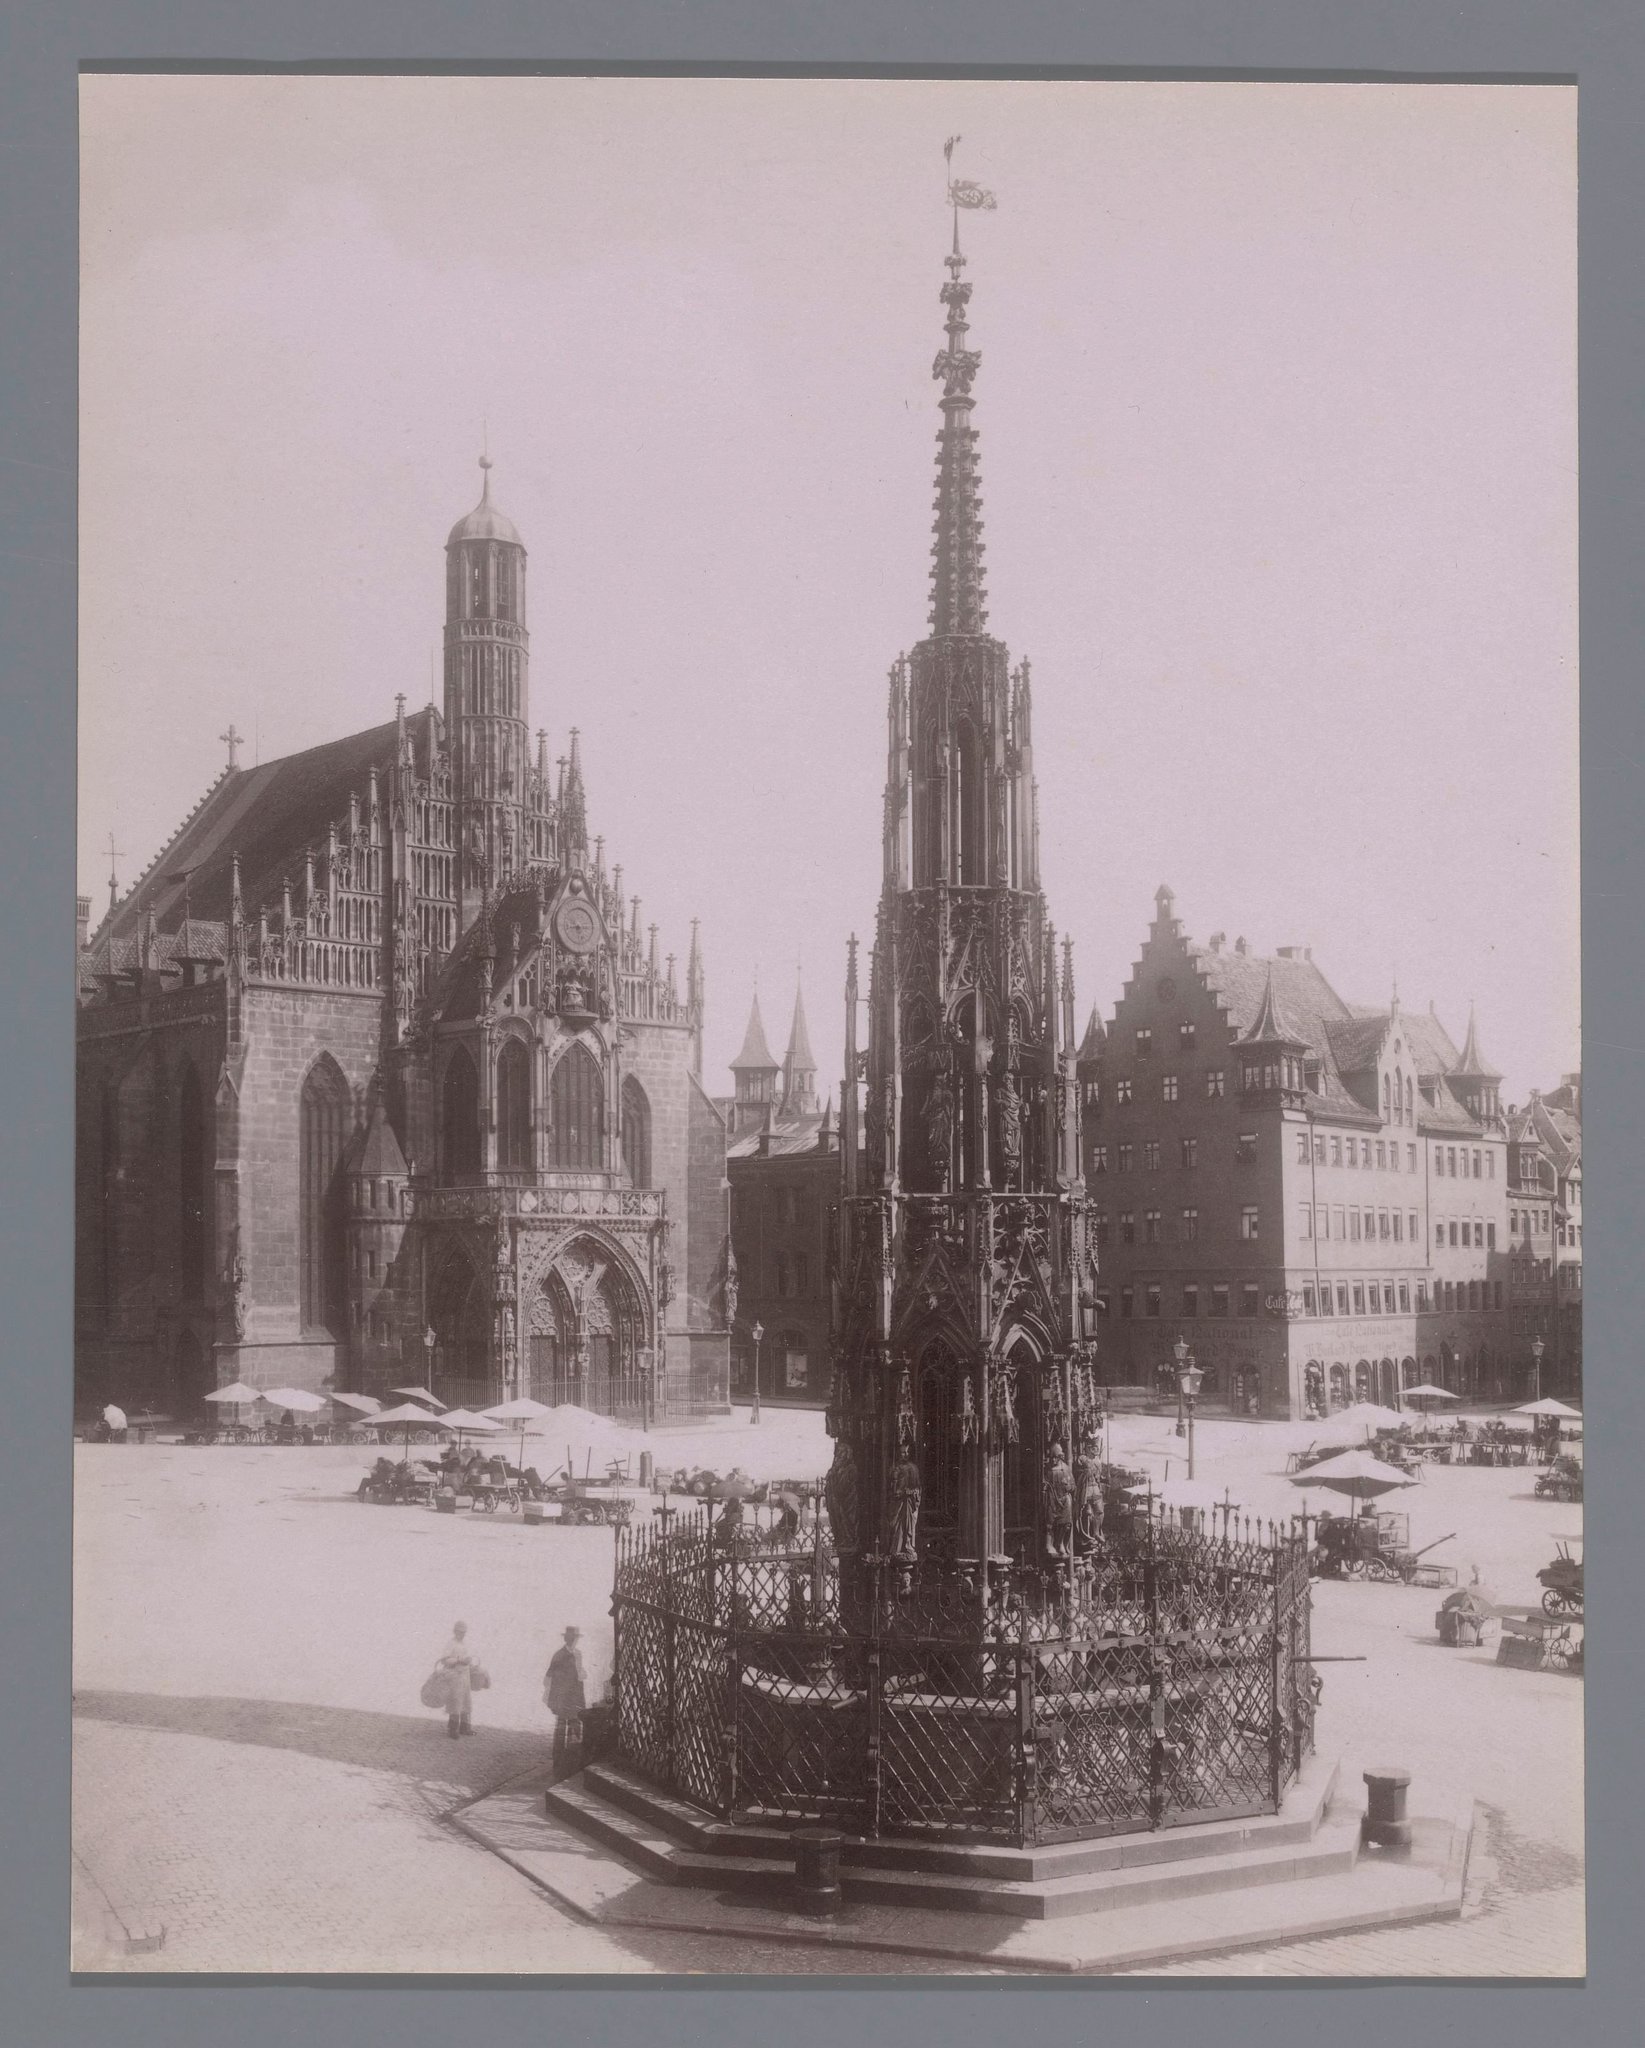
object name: photograph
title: Schöner Brunnen op de Hauptmarkt te Neurenberg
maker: ferdinand schmidt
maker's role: fotograaf, fotostudio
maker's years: 1840-1909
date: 1895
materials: paper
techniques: albumen print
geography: nuremberg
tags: church (exterior), ornamental fountain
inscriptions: check stamp: ‘Ferdinand Schmidt/ Nürnberg 1895.’, inscription: ‘Nürnberg’, number: ‘15’